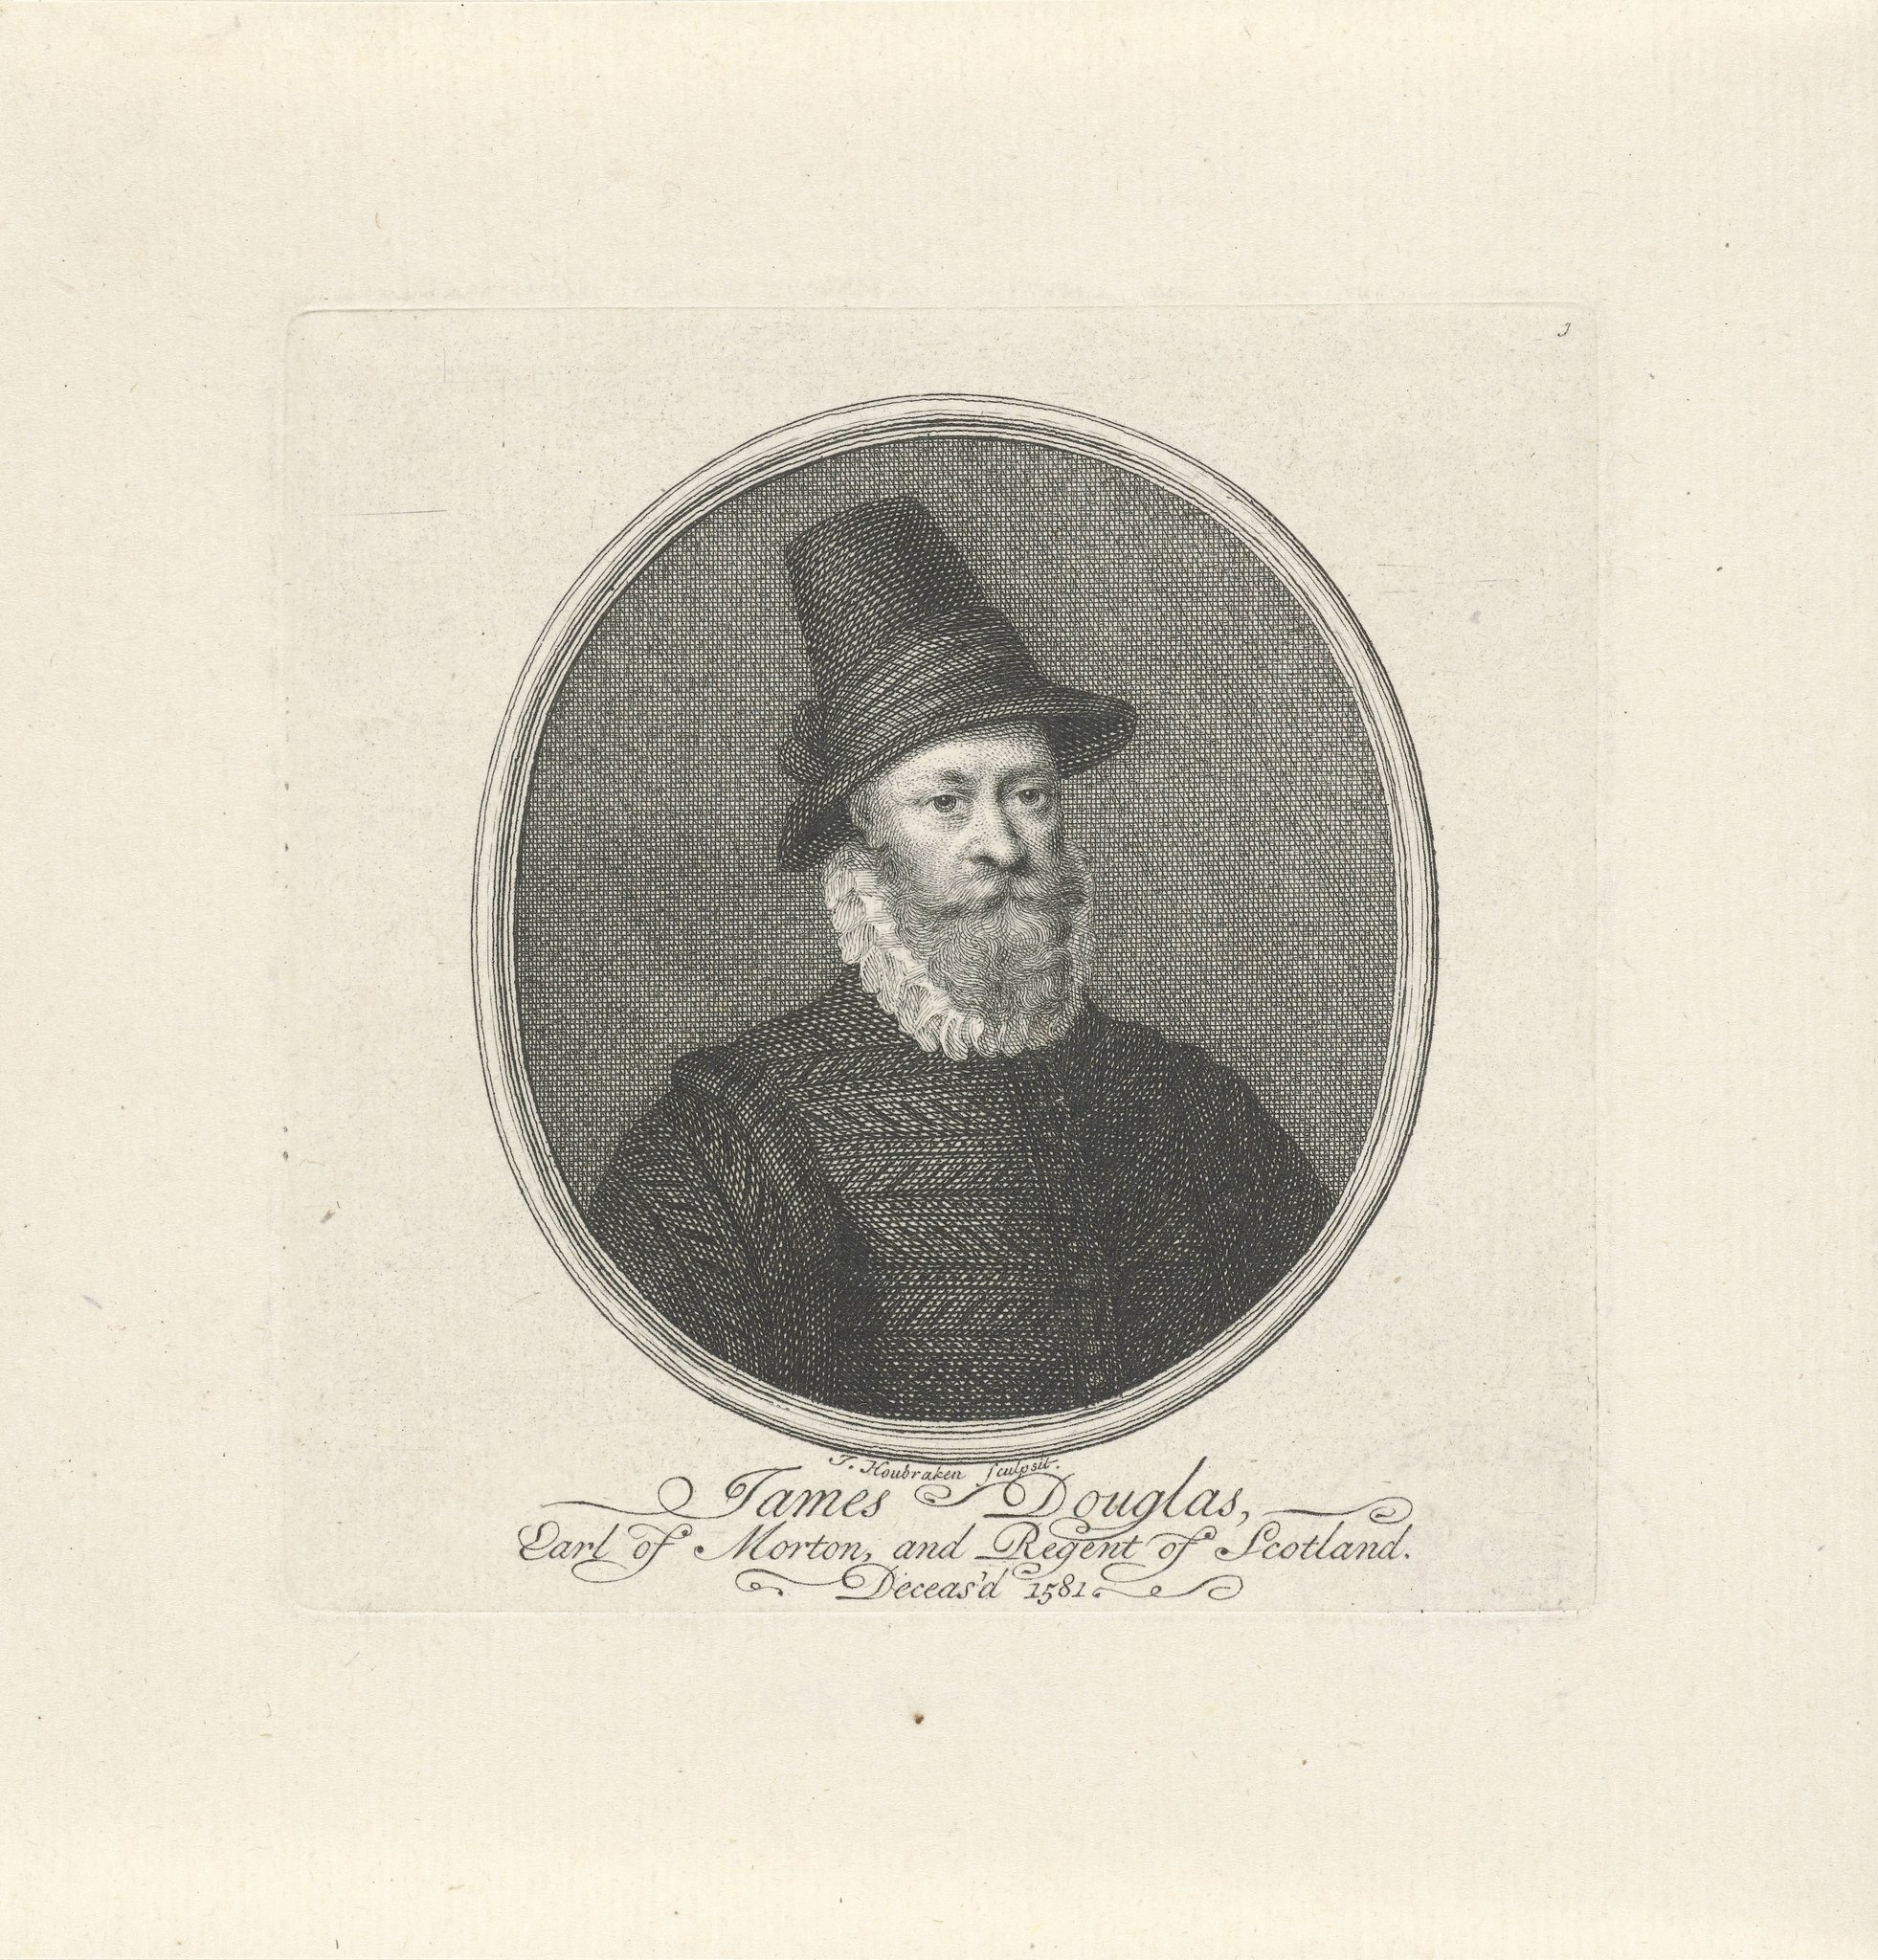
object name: print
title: Portret van James Douglas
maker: jacob houbraken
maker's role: draughtsman, print maker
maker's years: 1698-1780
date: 1708-1780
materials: paper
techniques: engraving, etching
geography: amsterdam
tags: soldaat, james douglas (4e graaf van morton)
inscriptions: collector's mark: Lugt 240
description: Buste van James Douglas, 4e graaf van Morton in een ovaal. Onder het portret drie regels in het Engels.